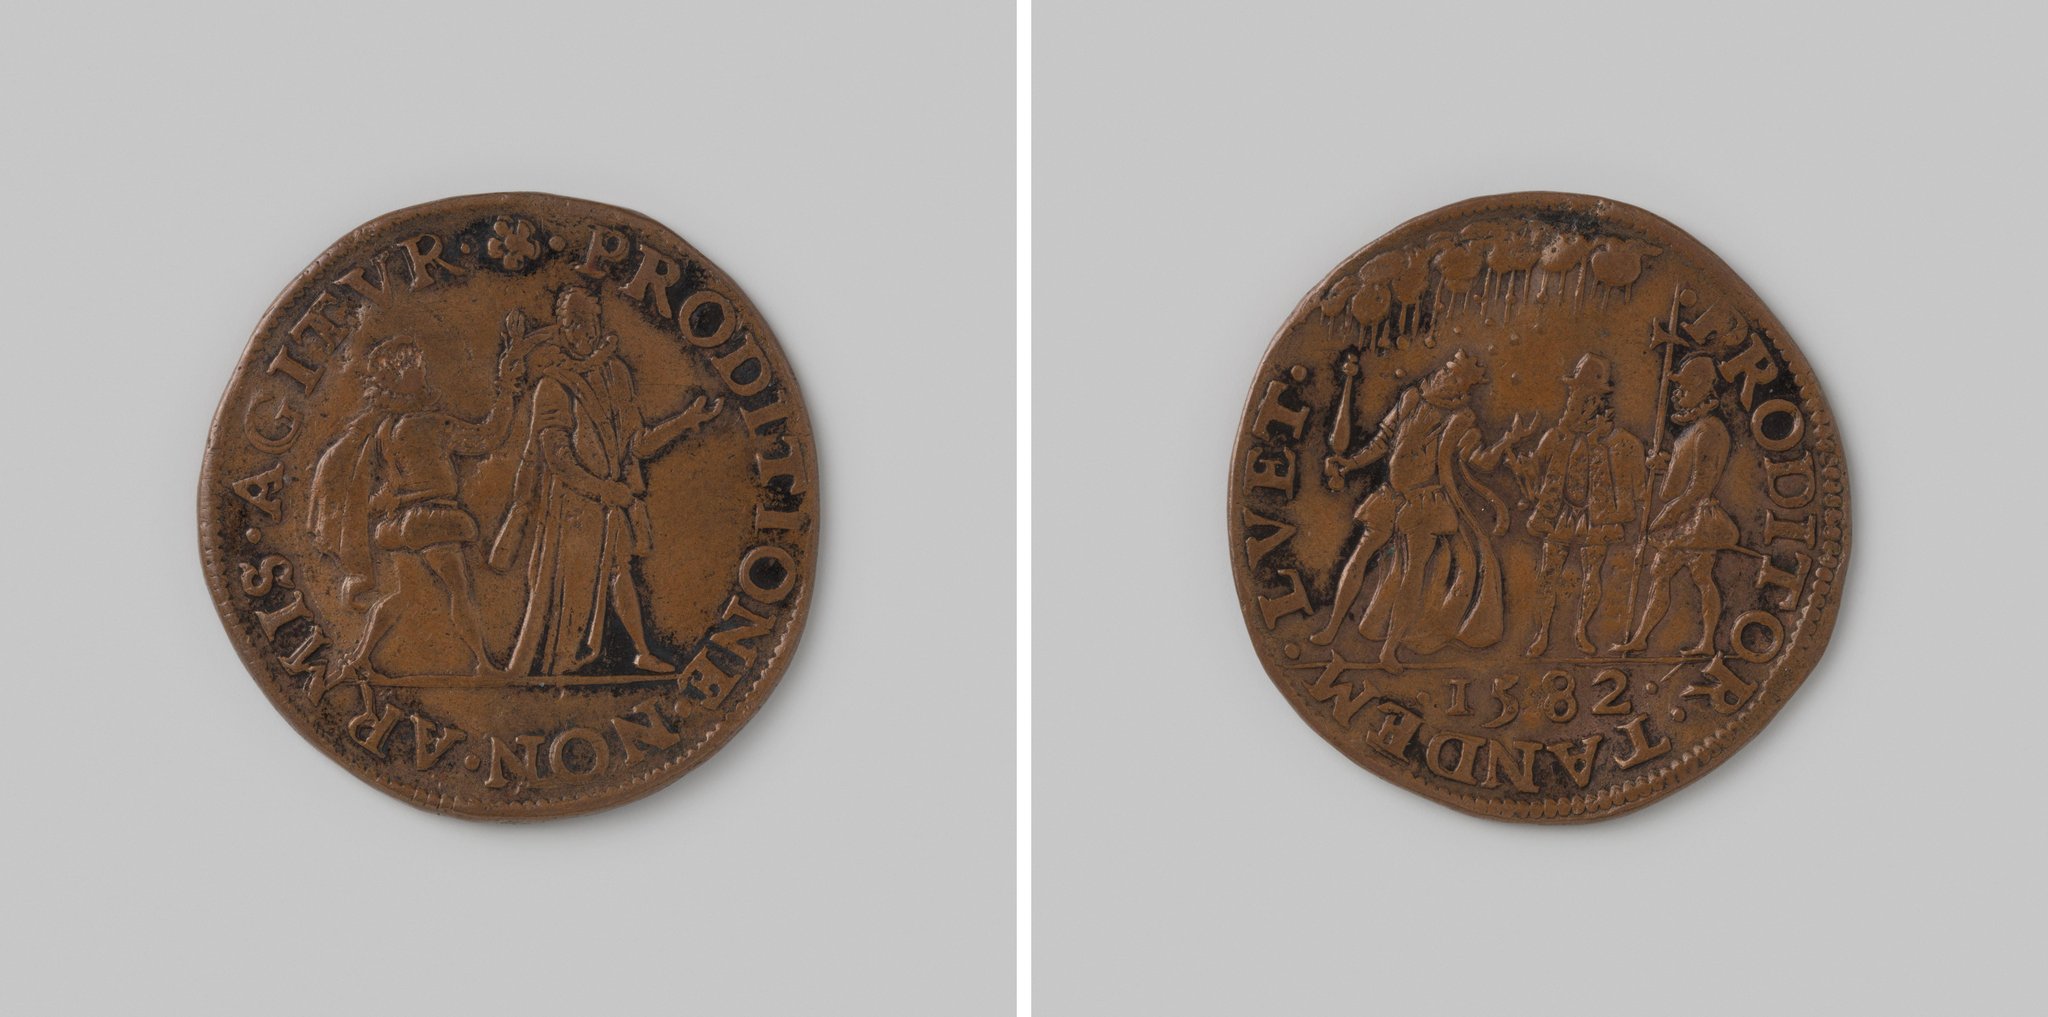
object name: history medal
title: Rekenpenning uit Dordrecht op de aanslag van Jean Jauregui op Willem van Oranje 1582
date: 1582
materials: copper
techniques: striking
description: Koperen penning, op de voorzijde Jauregui die op Willem van Oranje schiet, met omschrift, op de keerzijde Koning Philips II van Spanje stampvoetend en door een hagelbui geteisterd, naast een raadsheer en een soldaat, met omschrift en afsnedetekst.